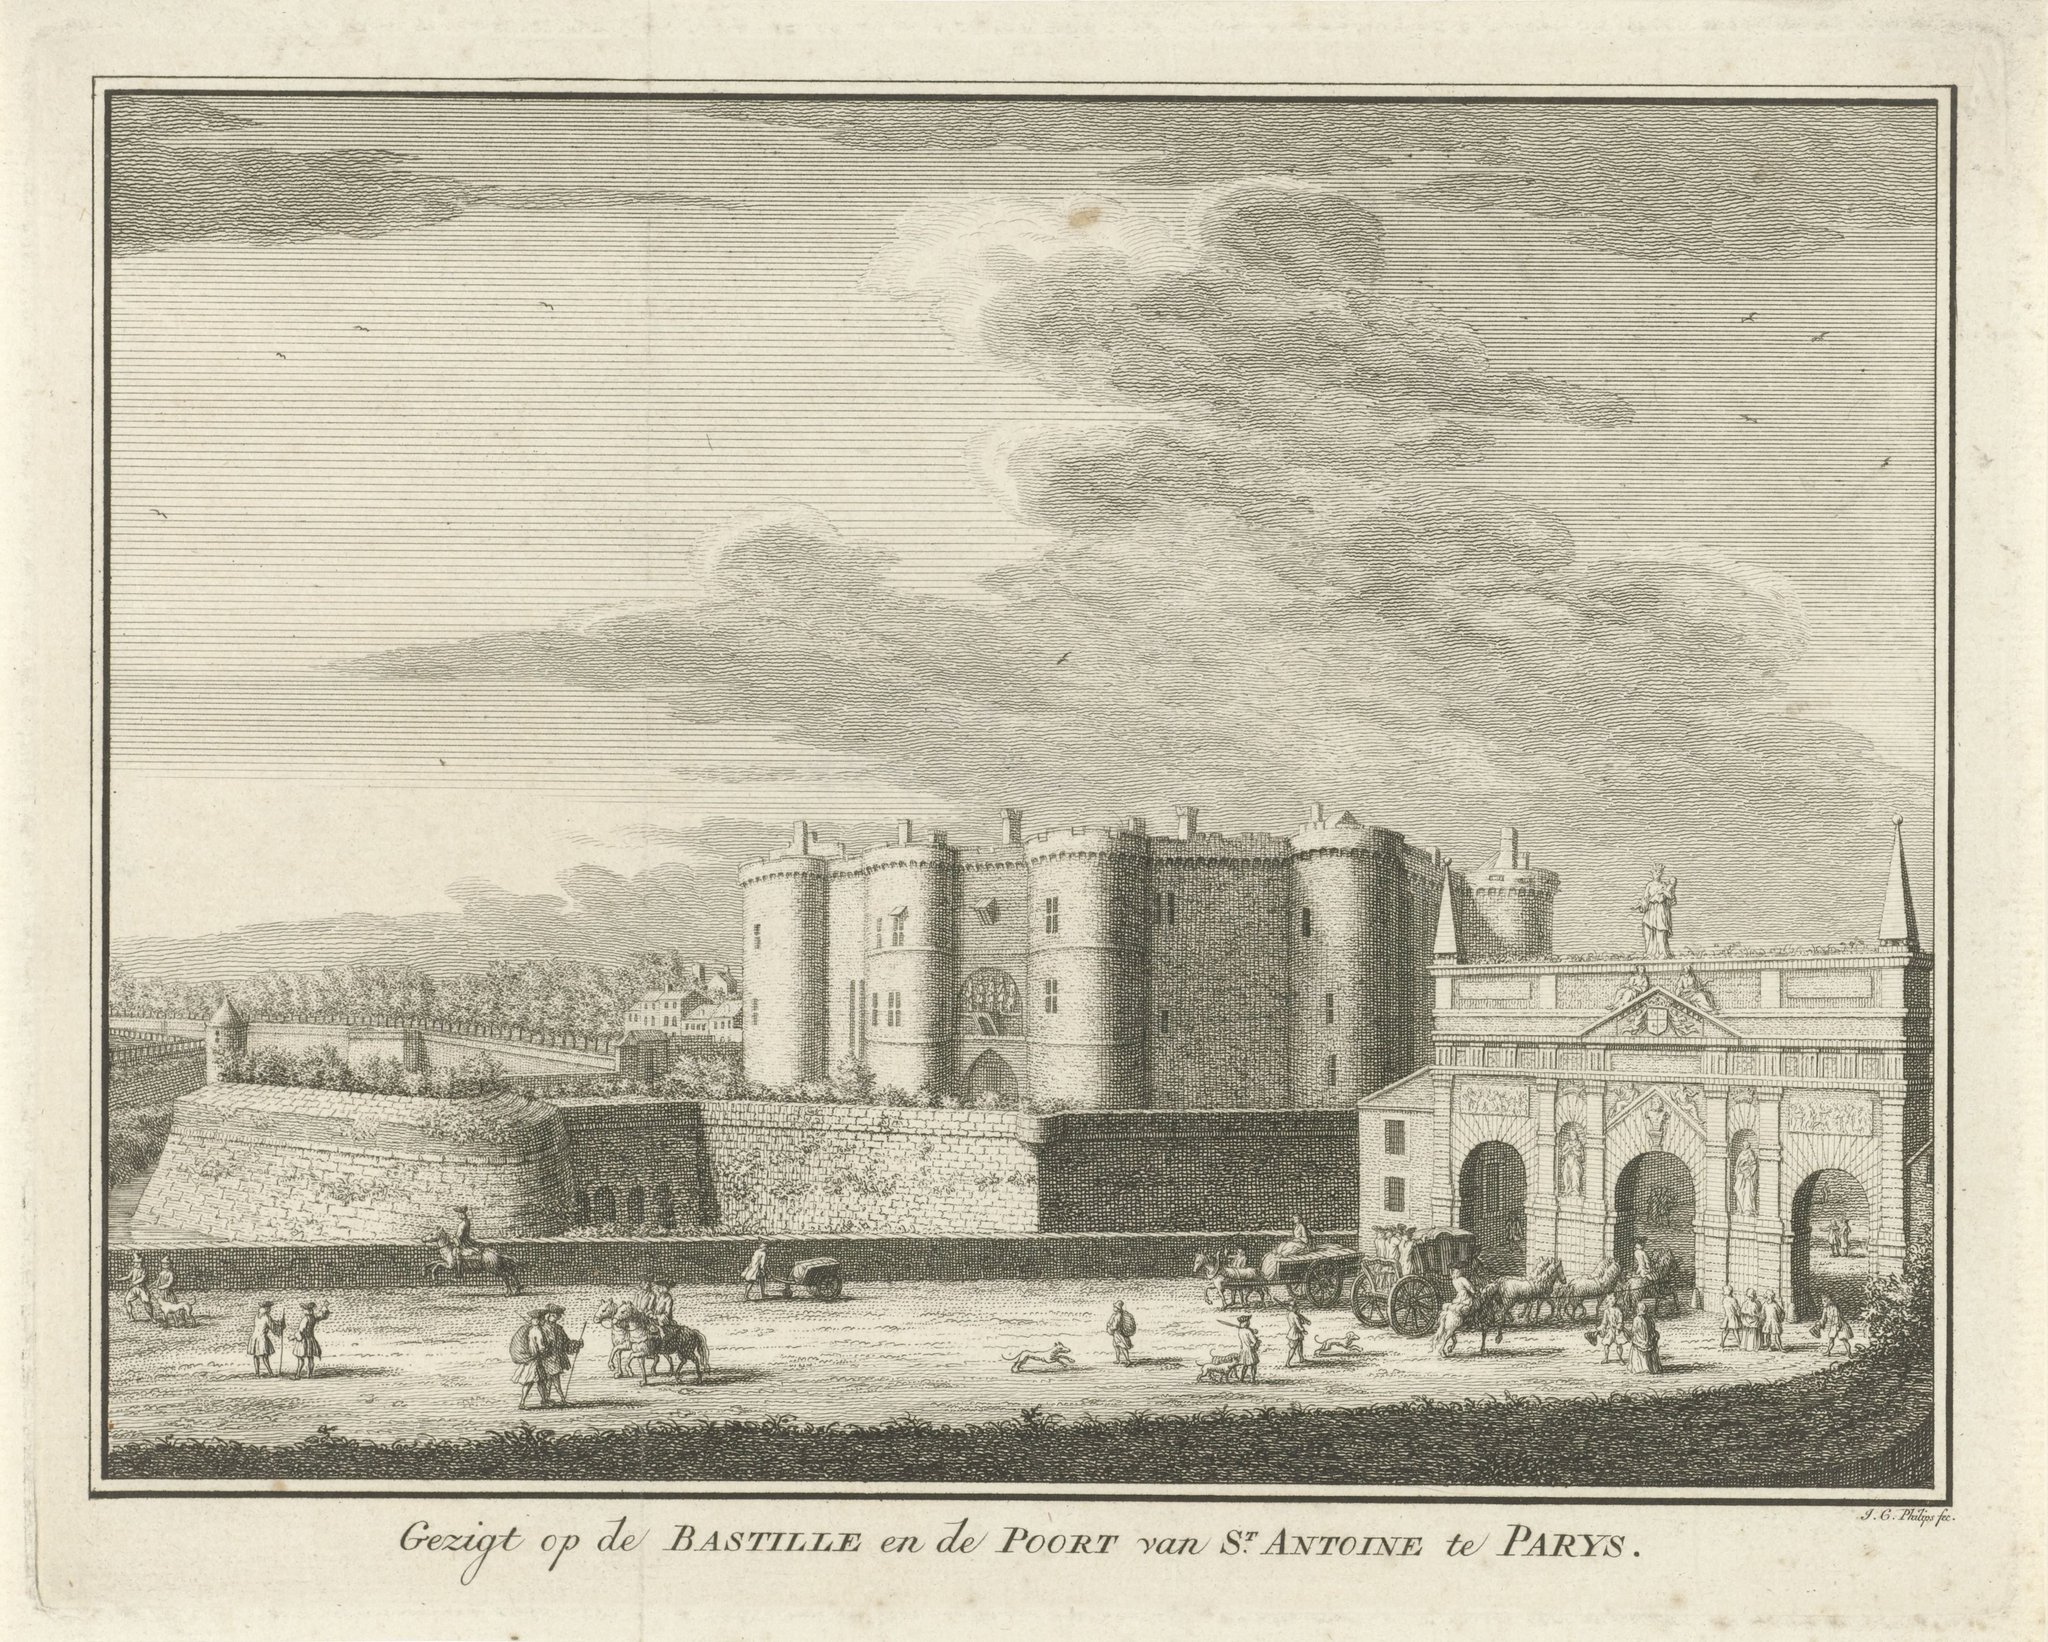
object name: print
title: Gezigt op de Bastille en de Poort van St. Antoine te Parys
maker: jan caspar philips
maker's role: draughtsman, print maker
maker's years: 1700-1775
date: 1736-1775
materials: paper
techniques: etching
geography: amsterdam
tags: fortress, city-gate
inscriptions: collector's mark: Lugt 2228